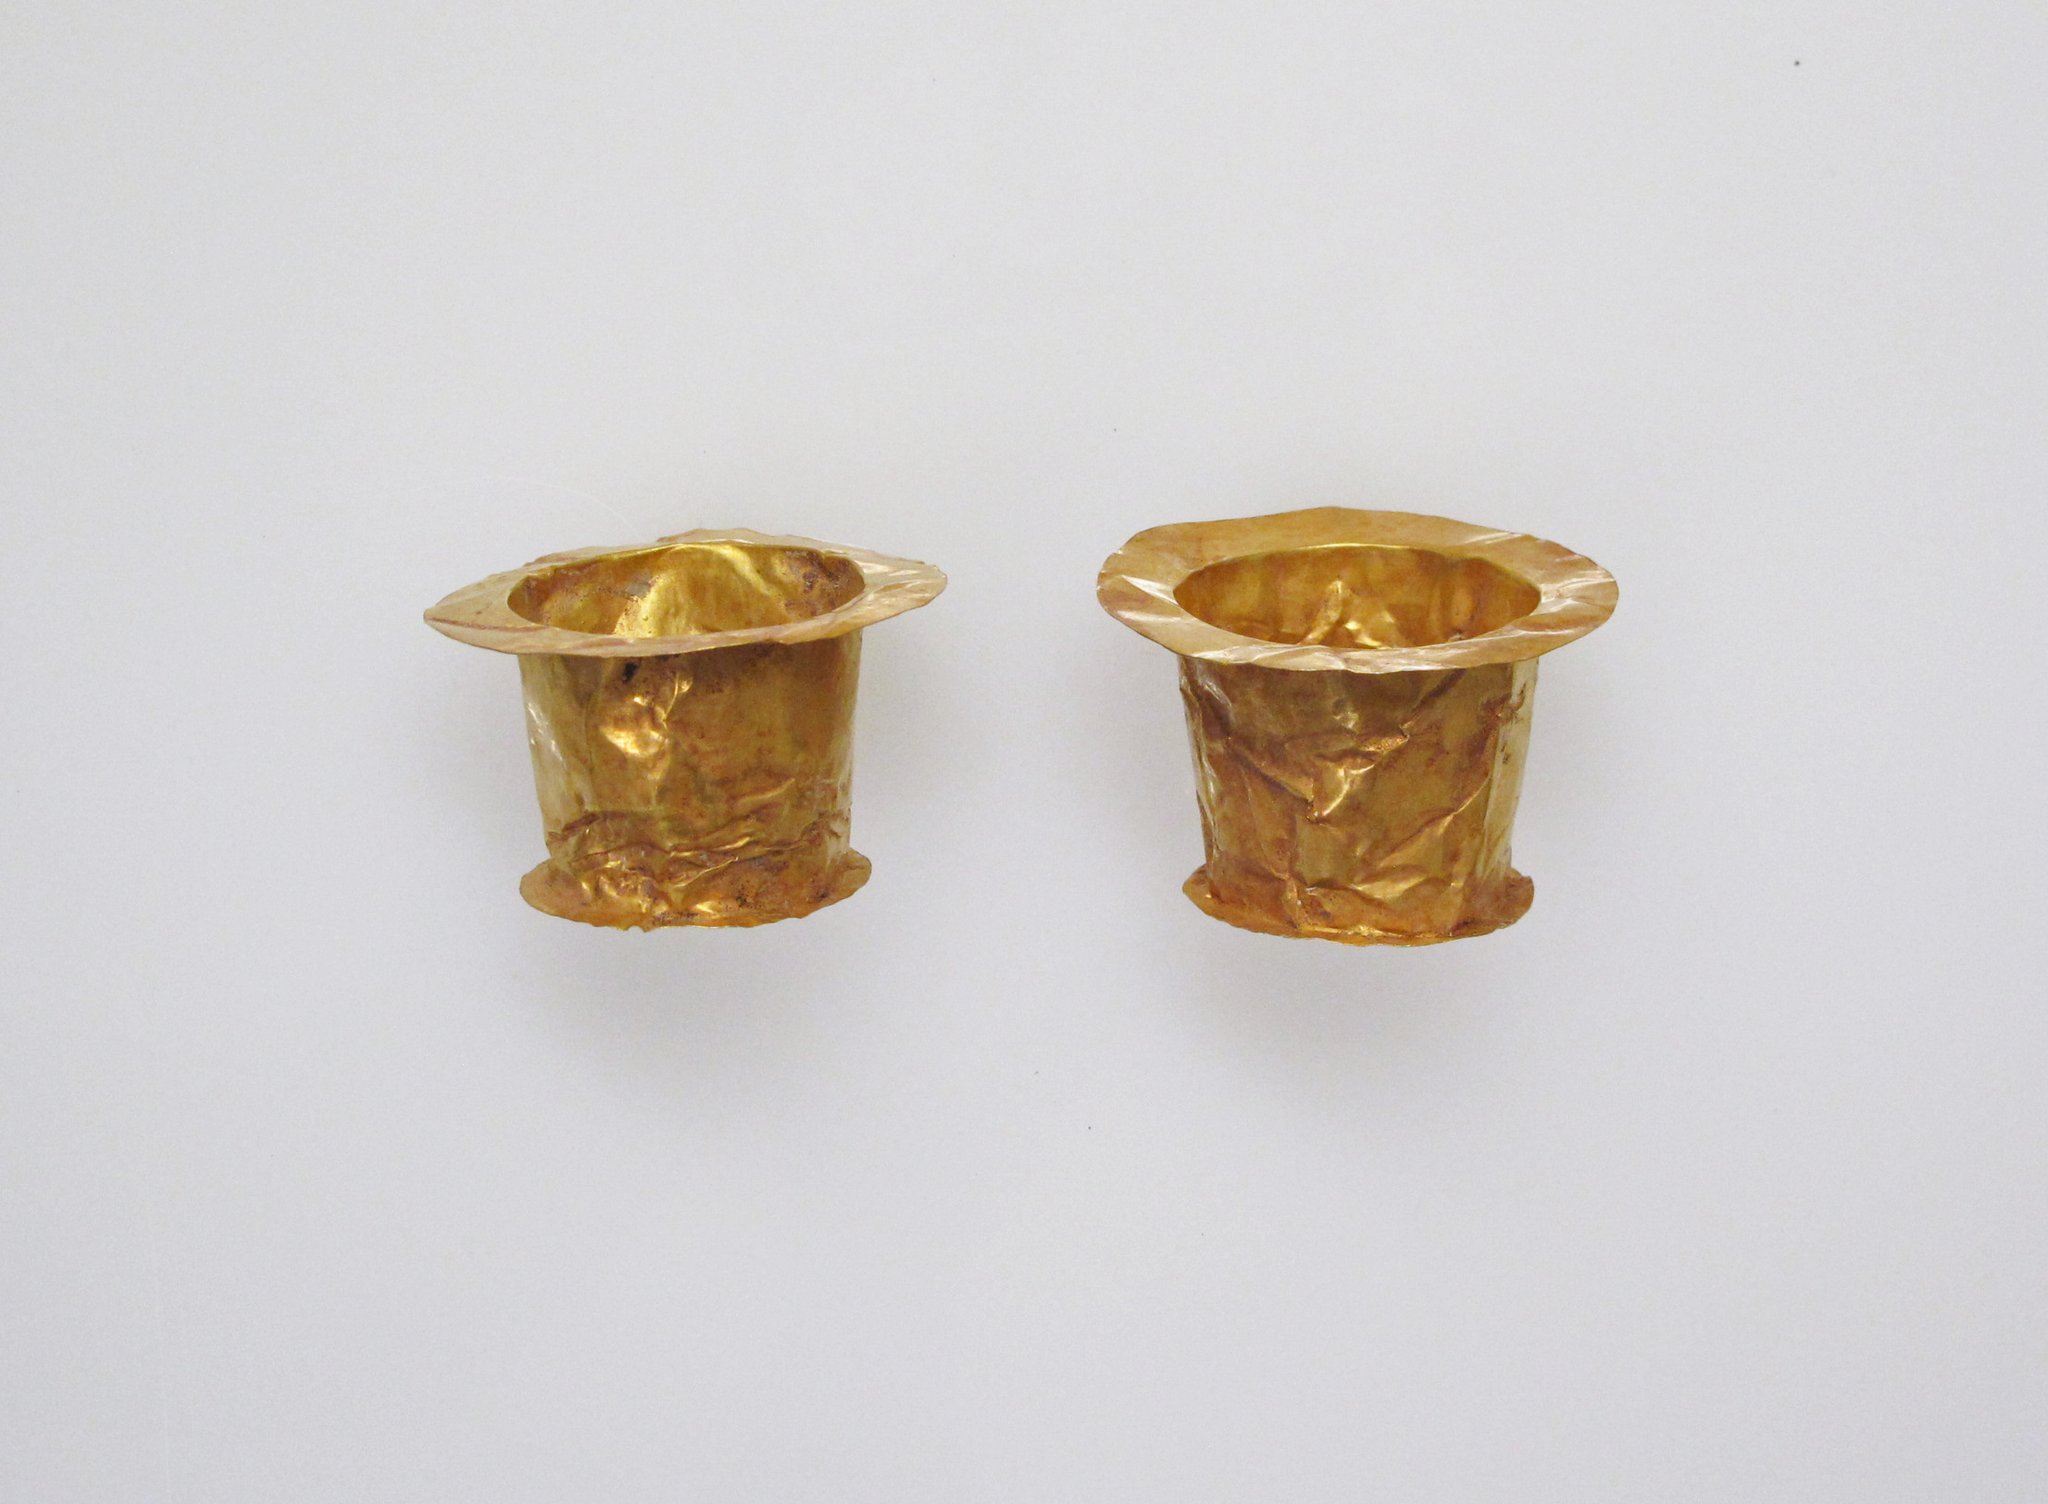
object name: stand, spool shaped, pair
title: Stands, spool-shaped, pair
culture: etruscan or greek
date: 534-401 BCE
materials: gold foil